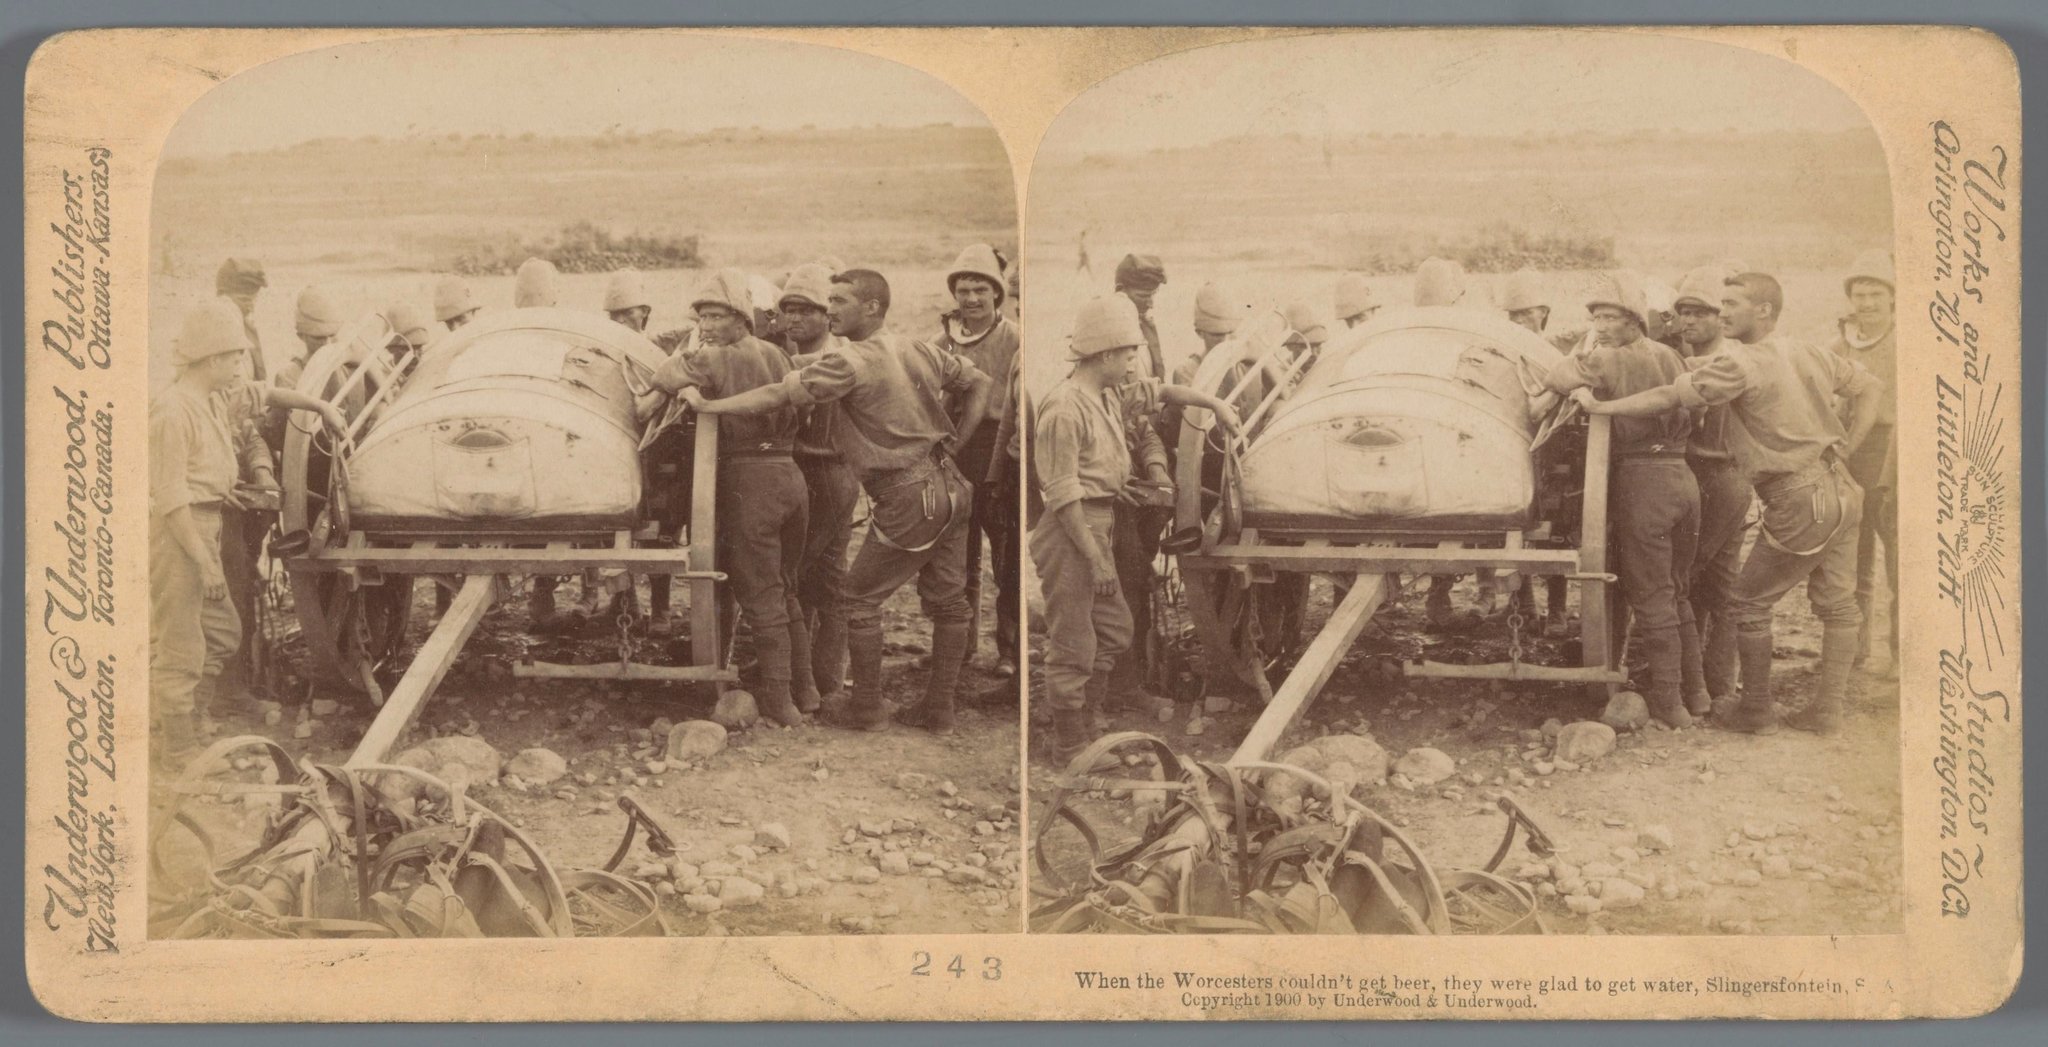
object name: stereograph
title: Mannen van het Worcestershire Regiment bij vermoedelijk een kar met water in Zuid-Afrika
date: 1900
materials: cardboard, photographic support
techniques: albumen print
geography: south africa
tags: the soldier; the soldier's life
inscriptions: name: ‘Works and Studios Sun Sculpture trade mark Arlington N.J. Littleton N.H. Washington D.C.’, number: ‘243’